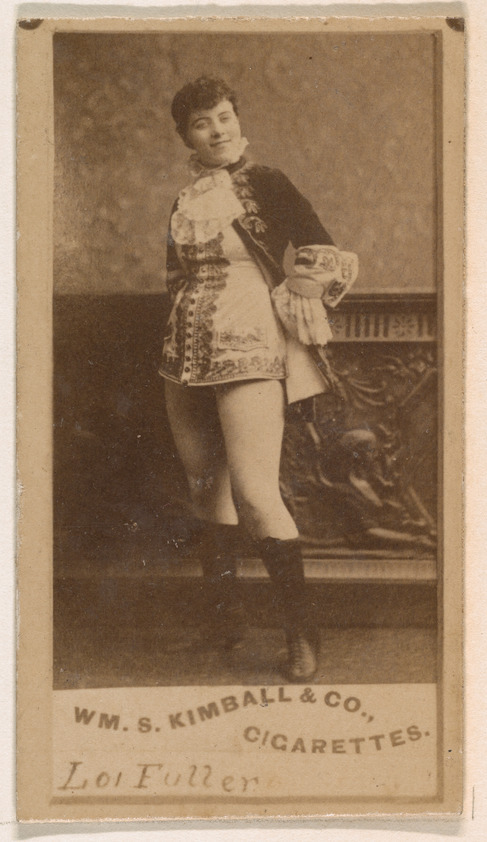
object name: photograph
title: Loie Fuller, from the Actresses series (N203) issued by Wm. S. Kimball & Co.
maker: william s. kimball & company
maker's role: publisher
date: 1889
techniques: color lithograph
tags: portraits,women,actresses